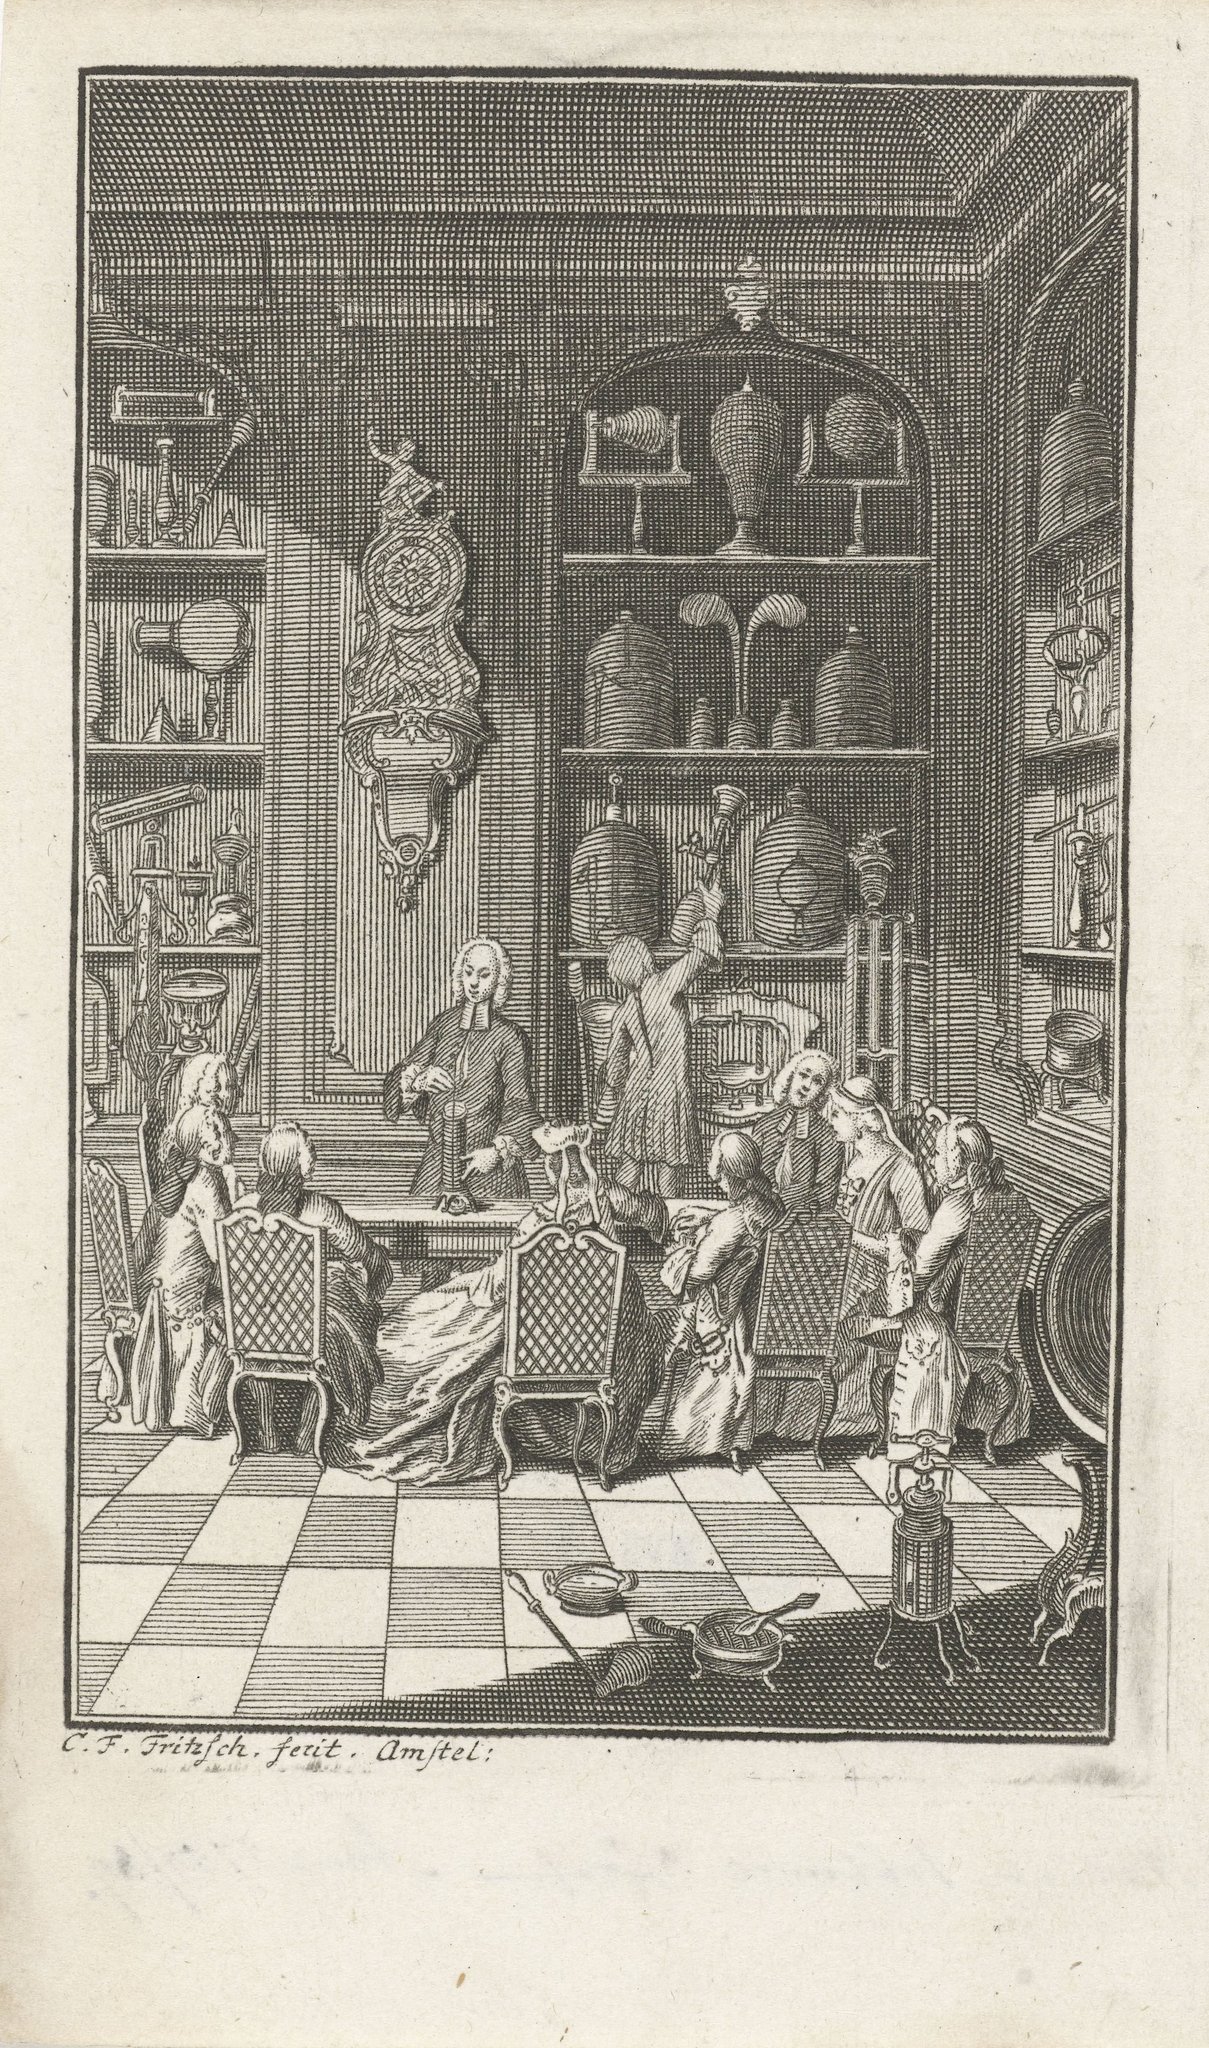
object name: book illustration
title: Natuurkundige les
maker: christian friedrich fritzsch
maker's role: print maker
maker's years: 1719-1774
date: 1759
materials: paper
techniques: etching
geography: amsterdam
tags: laboratory, research room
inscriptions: collector's mark: Lugt 2228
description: Een gezelschap, bestaande uit acht heren en twee dames, zit rond een tafel in een laboratorium. In de kasten en op de grond staan (meet)instrumenten voor natuurkundig onderzoek.